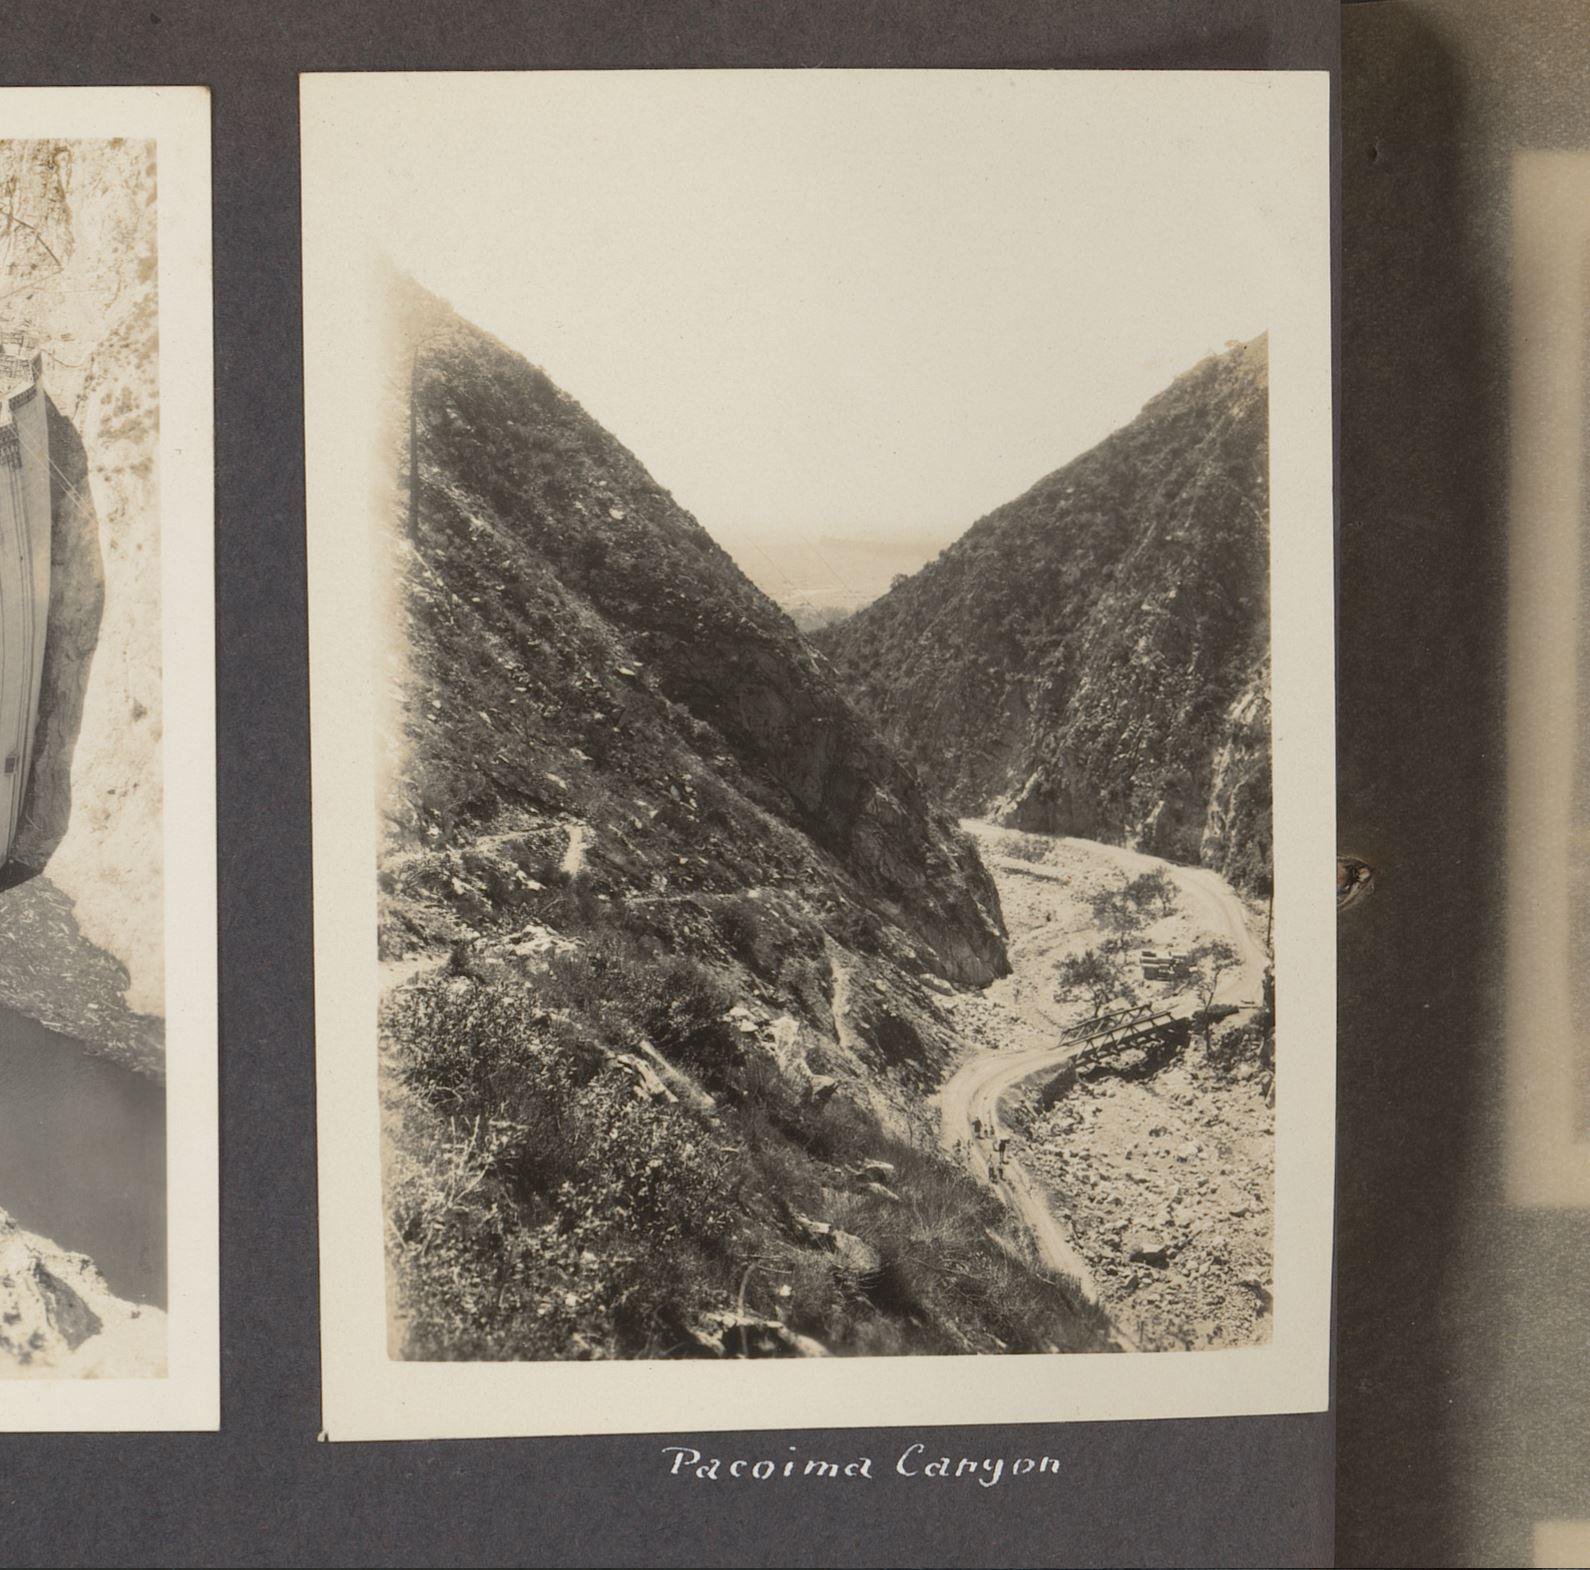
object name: photograph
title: Gezicht op Pacoima Canyon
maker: Anonymous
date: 1928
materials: photographic support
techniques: gelatin silver print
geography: pacoima canyon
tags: ravine, chasm, abyss, canyon, mountains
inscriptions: annotation: ‘Pacoima Canyon’